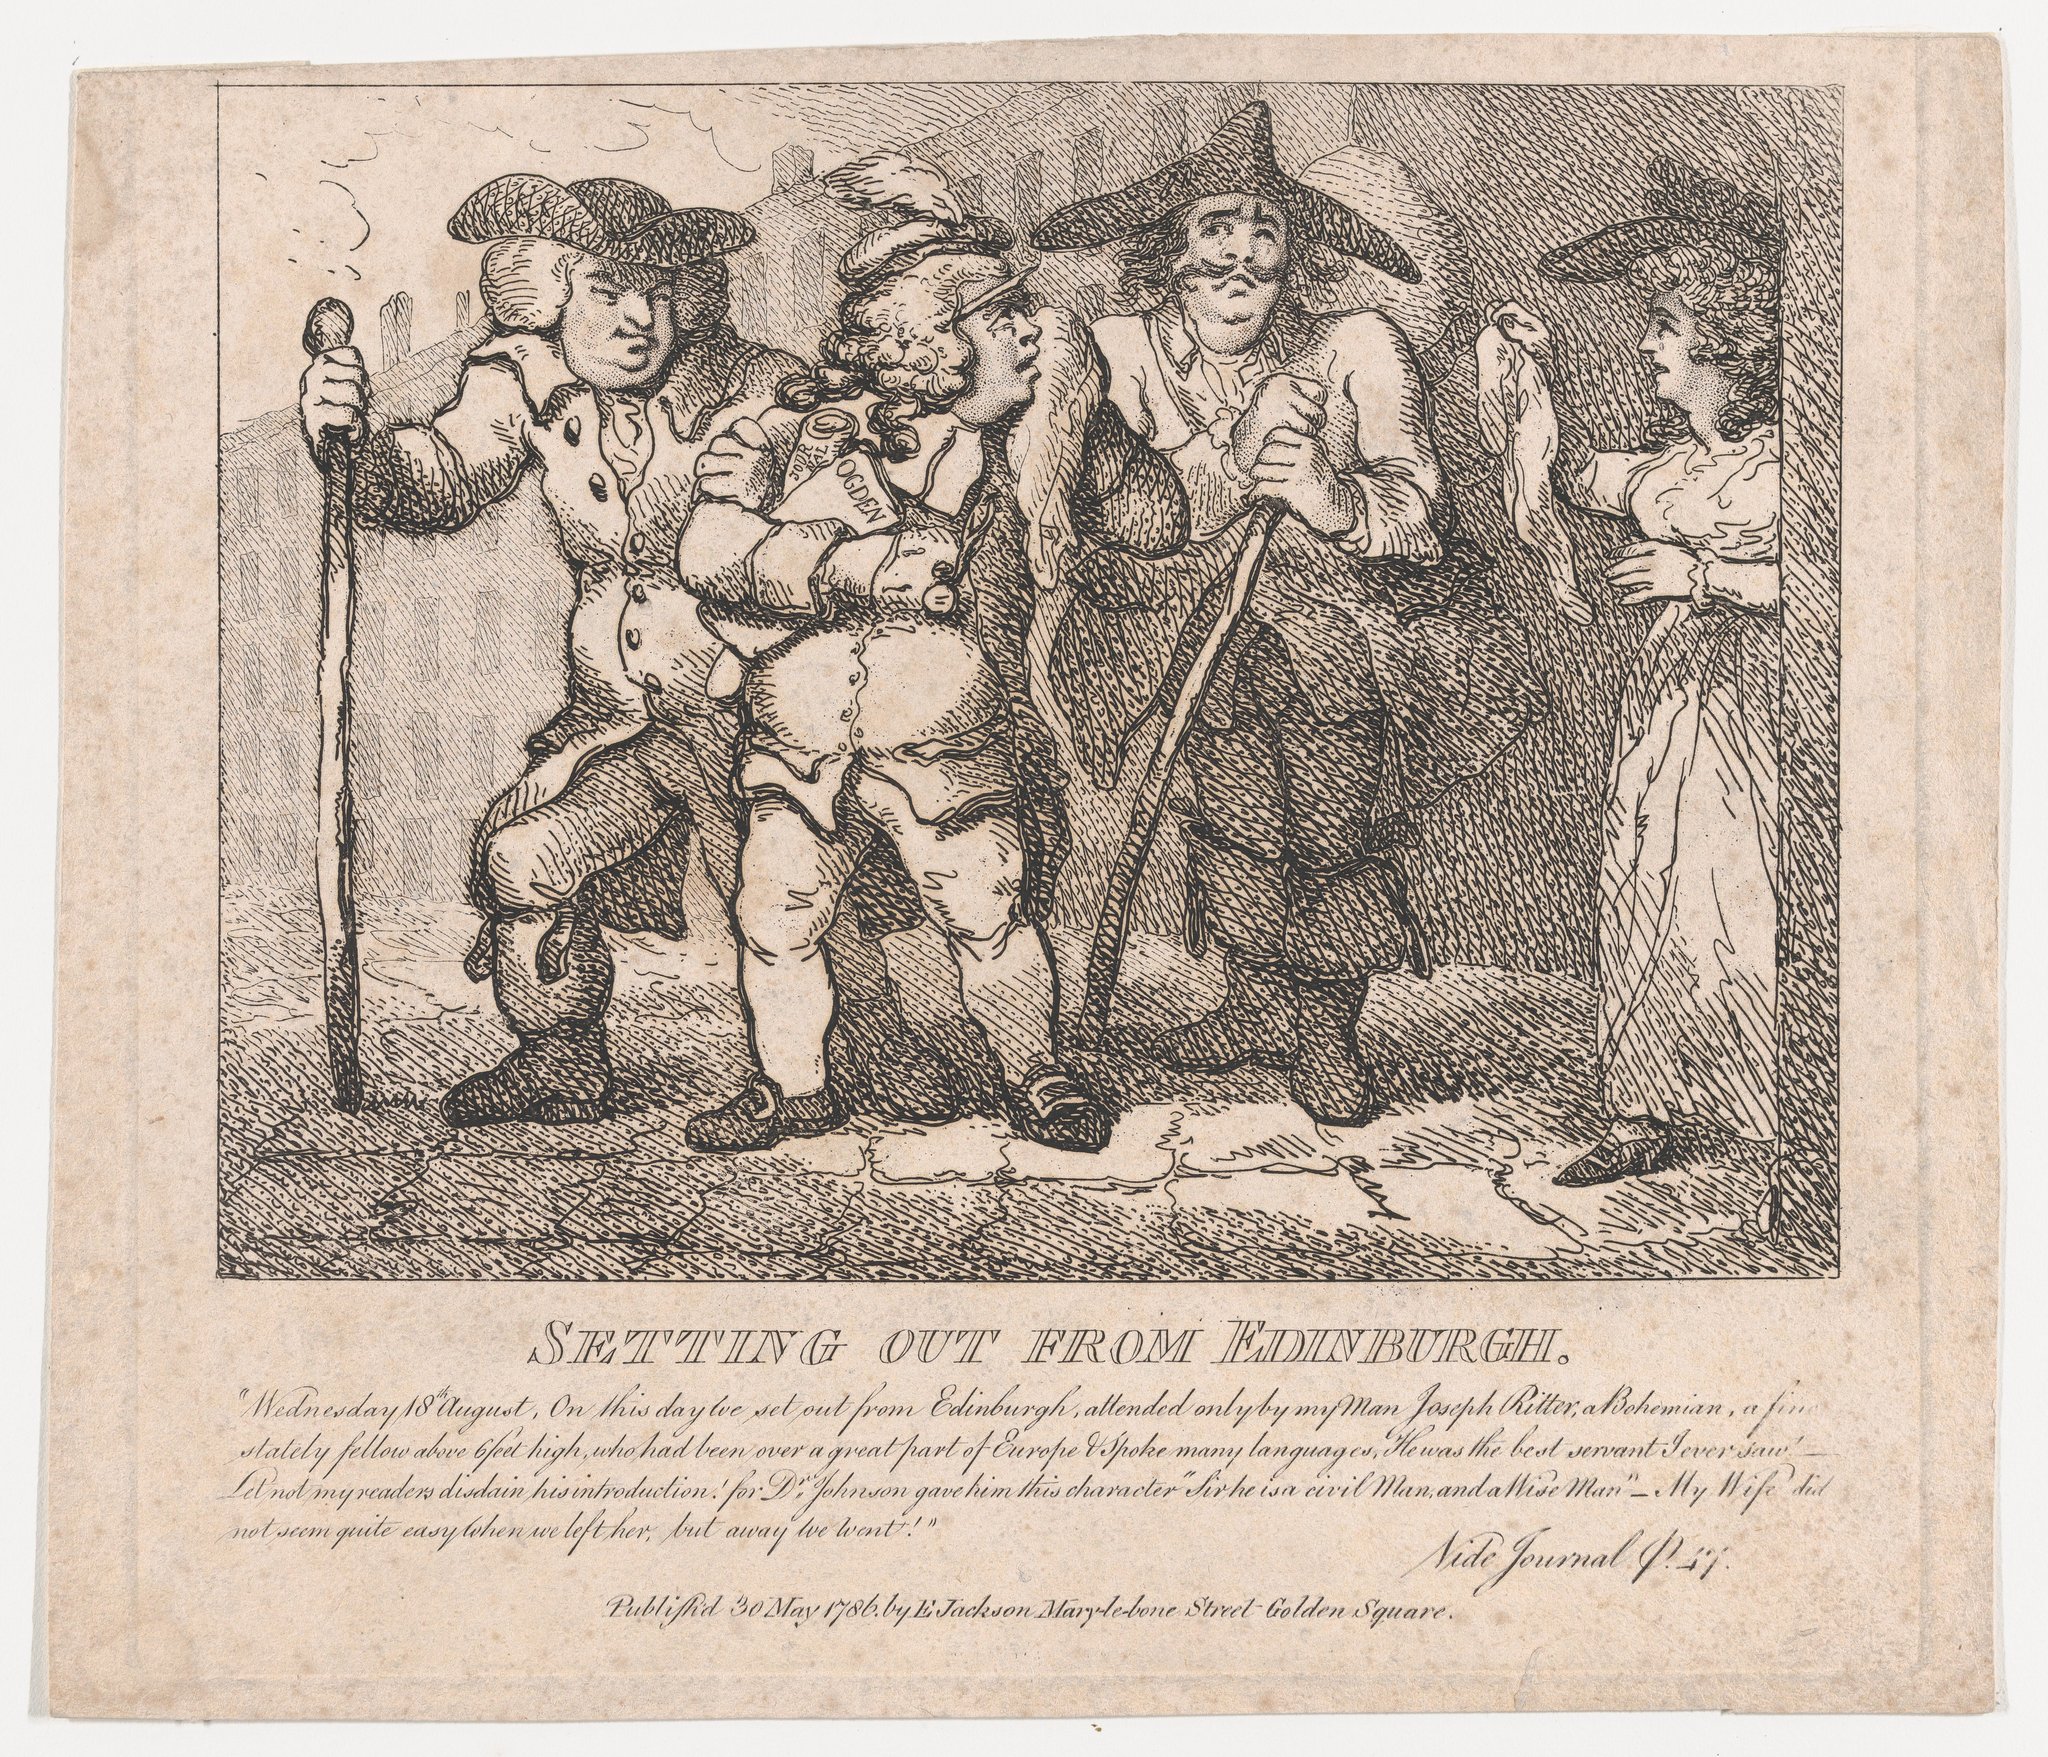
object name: print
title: Setting out from Edinburgh (Picturesque Beauties of Boswell, Part the Second)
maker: thomas rowlandson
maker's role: artist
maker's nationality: british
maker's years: 1757-1827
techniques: etching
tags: men,women